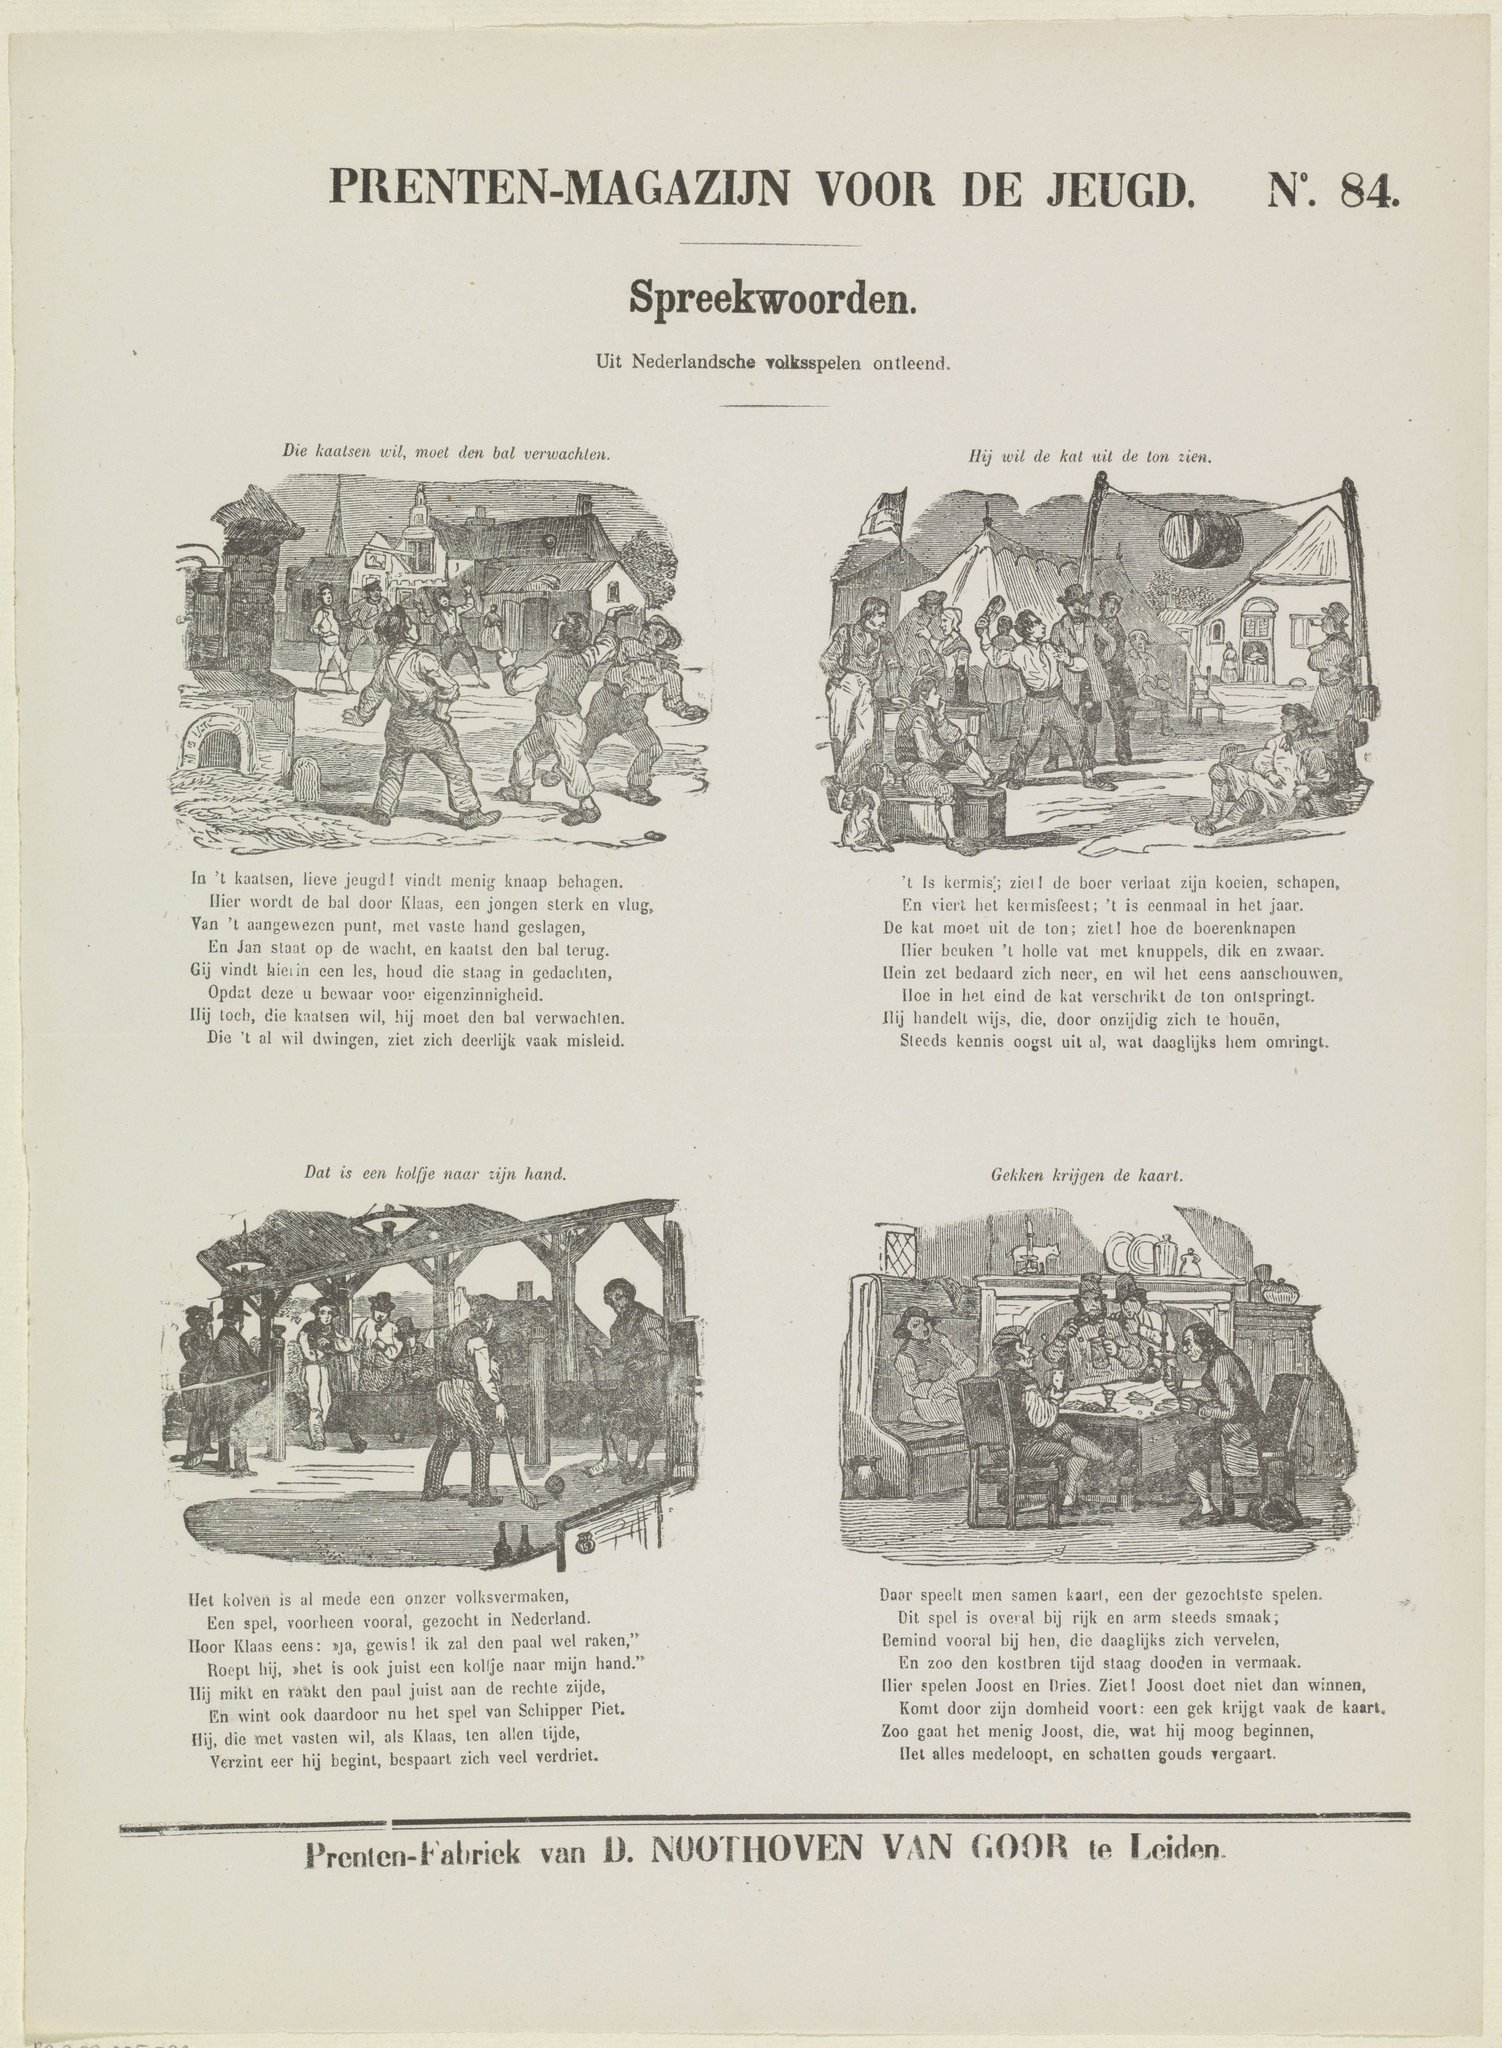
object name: popular print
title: Prenten-magazijn voor de jeugd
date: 1850-1881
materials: paper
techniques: letterpress printing, engraving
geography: netherlands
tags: children's games and plays, proverbs, sayings, etc.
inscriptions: collector's mark: Lugt 2760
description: Blad met 4 verbeeldingen van spreekwoorden, gebaseerd op Nederlandse volksspelen. Boven elke voorstelling een titel en onder elke voorstelling een achtregelig vers. Genummerd rechtsboven: No. 84.